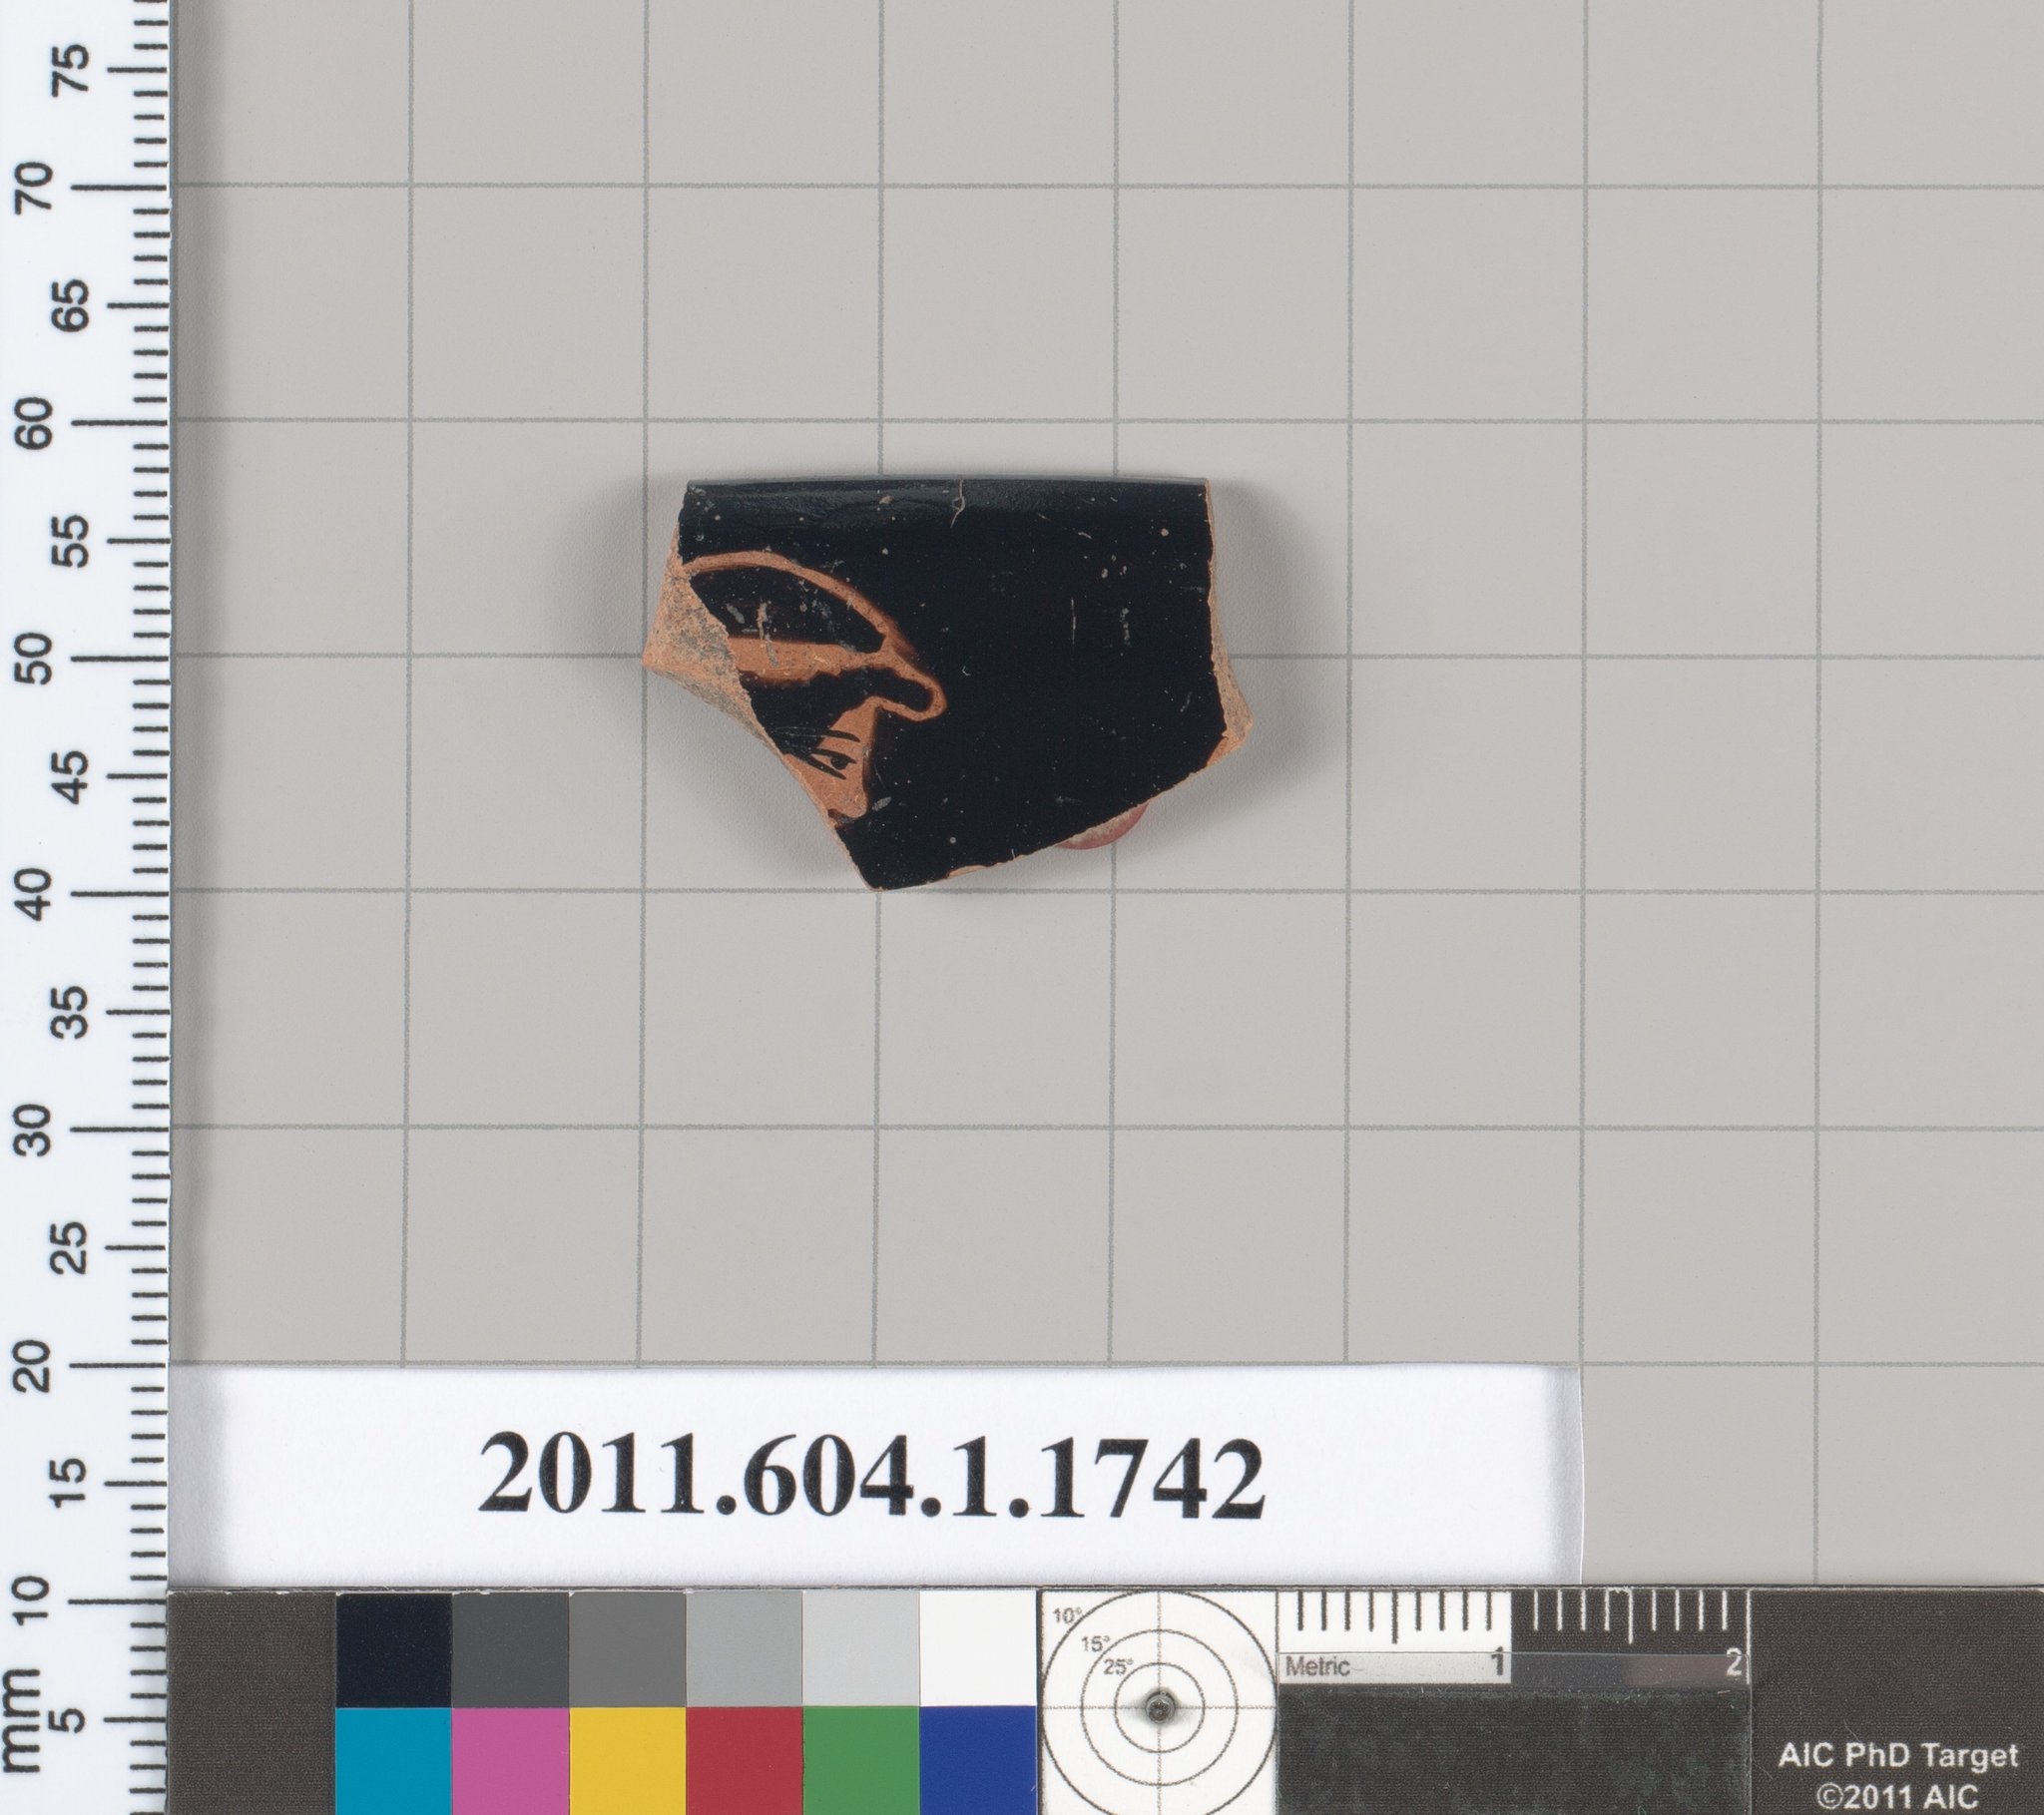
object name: kylix fragment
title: Terracotta rim fragment of a kylix (drinking cup)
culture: greek, attic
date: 475-451 BCE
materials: terracotta